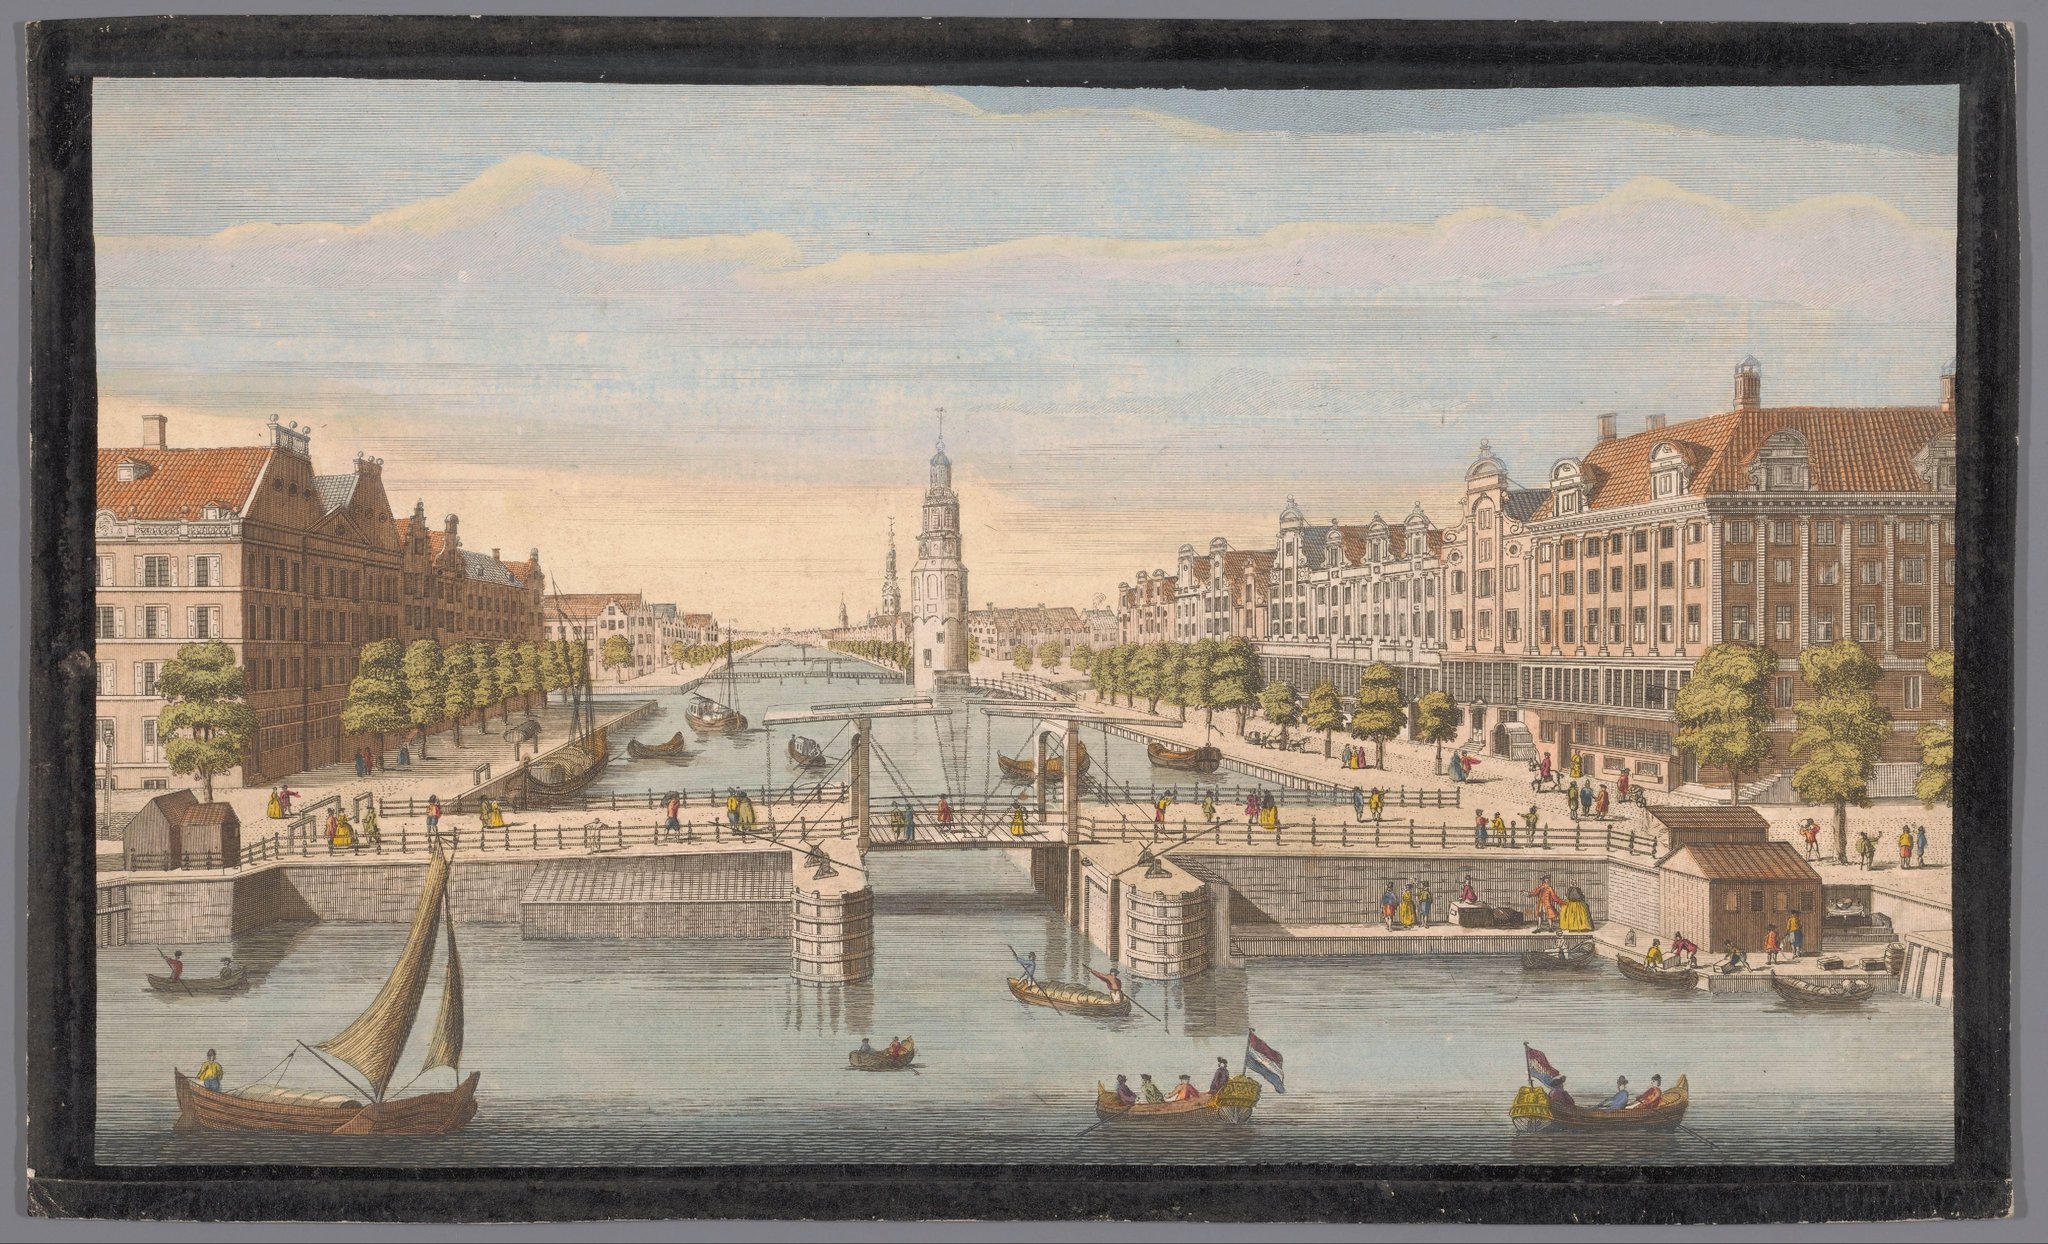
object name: print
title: Gezicht op de Oudeschans te Amsterdam gezien vanaf het IJ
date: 1752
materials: cardboard, paper, watercolor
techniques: brush, etching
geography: london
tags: bridge in city across river, canal, etc. (+ city(-scape) with figures, staffage), sailing-ship, sailing-boat, tower, clock tower ~ monumental adornment, church (exterior), rowing-boat, canoe, etc.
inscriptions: collector's mark: Lugt 2233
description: De serie “Holland” bevat negen prenten met de nummers 1-9, waarvan dit nummer 4 is.